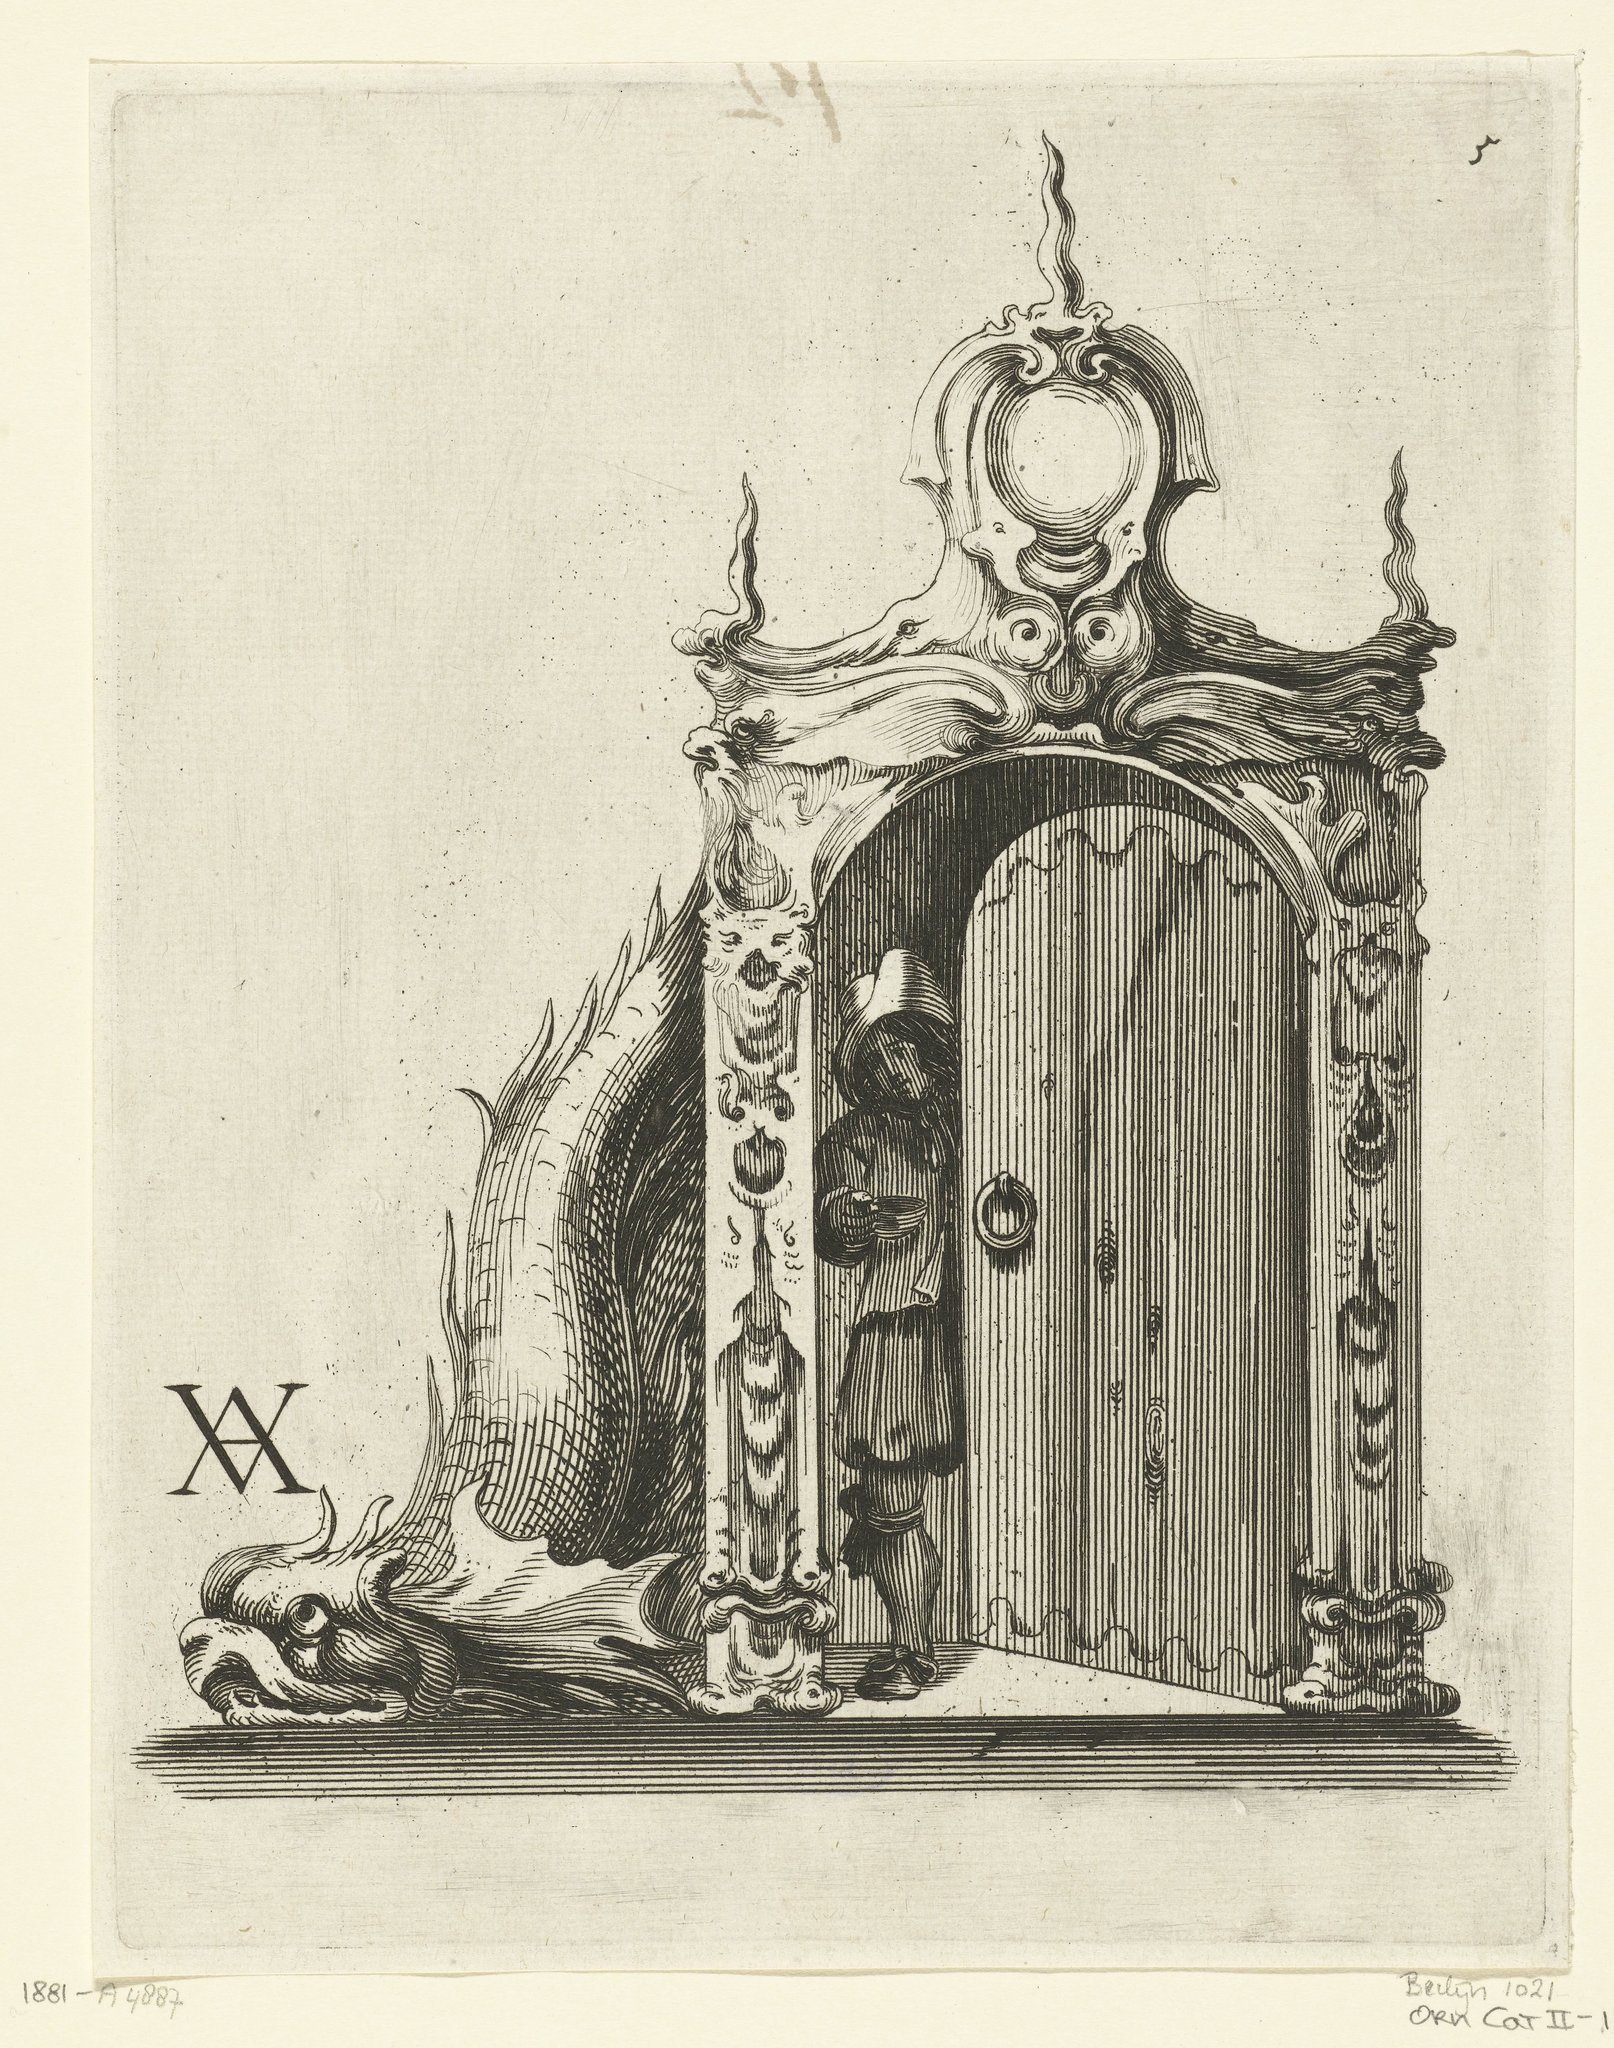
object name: print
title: Modelli artificiosi di vasi diversi d'argentosi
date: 1646-1652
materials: paper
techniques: etching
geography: utrecht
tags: dolphin ~ ornament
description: De deurpost is gedecoreerd met kwabornamenten en is bekroond met een cartouche. Achter de half geopende deur staat een jongeman met een kleine kom in de hand. Een enorme dolfijn ligt tegen de deurpost.